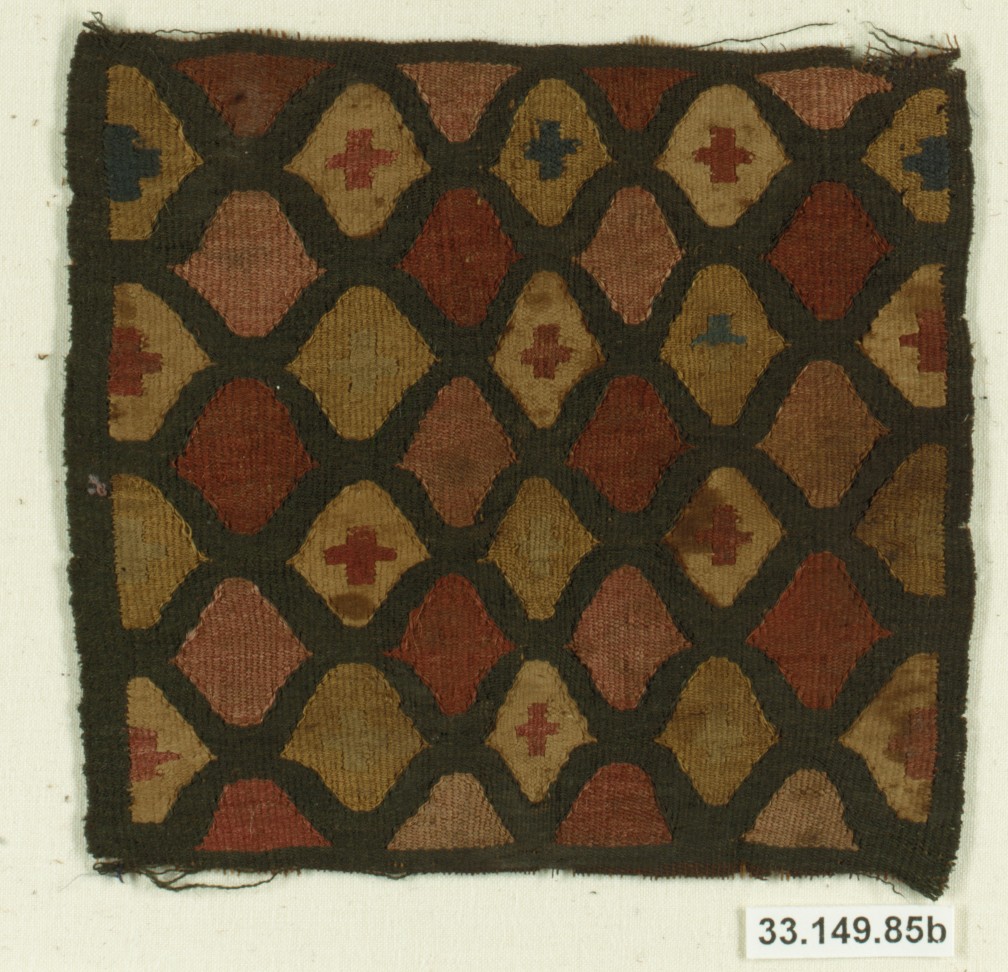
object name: panel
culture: wari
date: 601-1200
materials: animal fiber, cotton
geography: peru